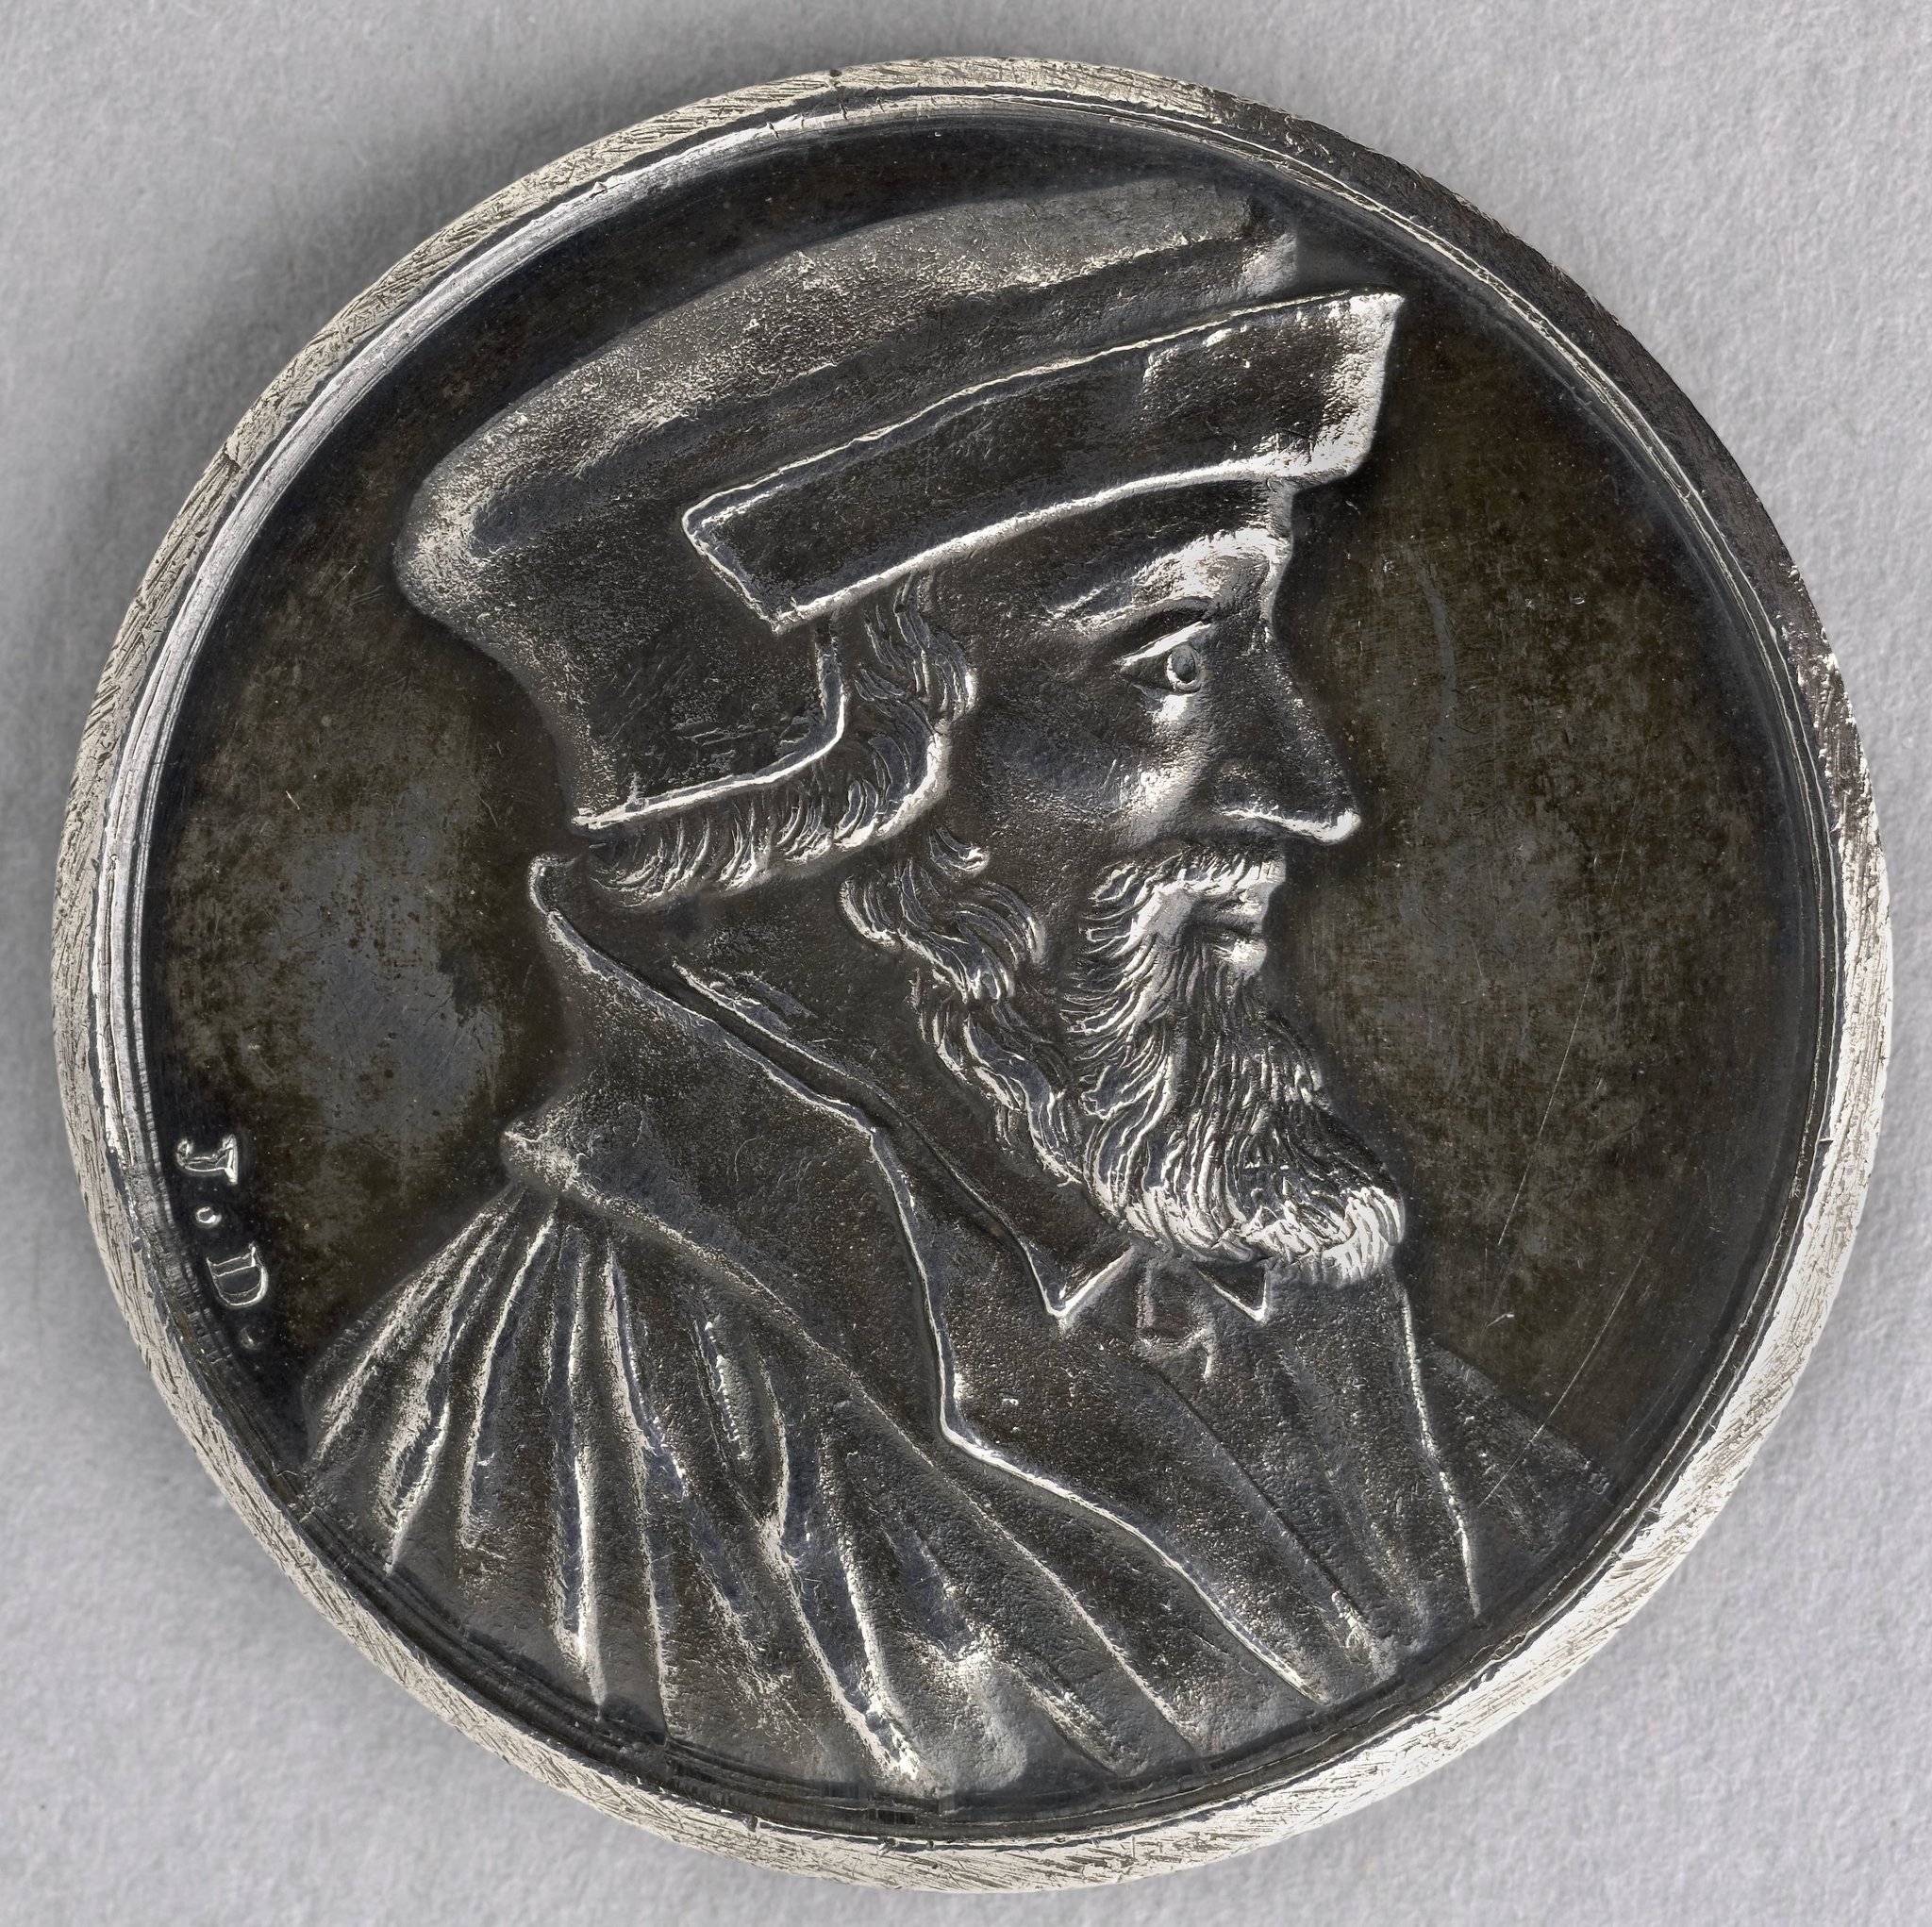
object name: history medal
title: Dood van Jan Huisschijn, bijgenaamd Oecolampadius, prediker te Basel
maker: jean dassier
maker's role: medailleur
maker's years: 1676-1763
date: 1725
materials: silver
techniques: striking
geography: geneva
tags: weinsberg, bazel, theoloog, johannes oecolampadius, reformatie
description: Zilveren penning. Voorzijde: borststuk man. Keerzijde: opschrift